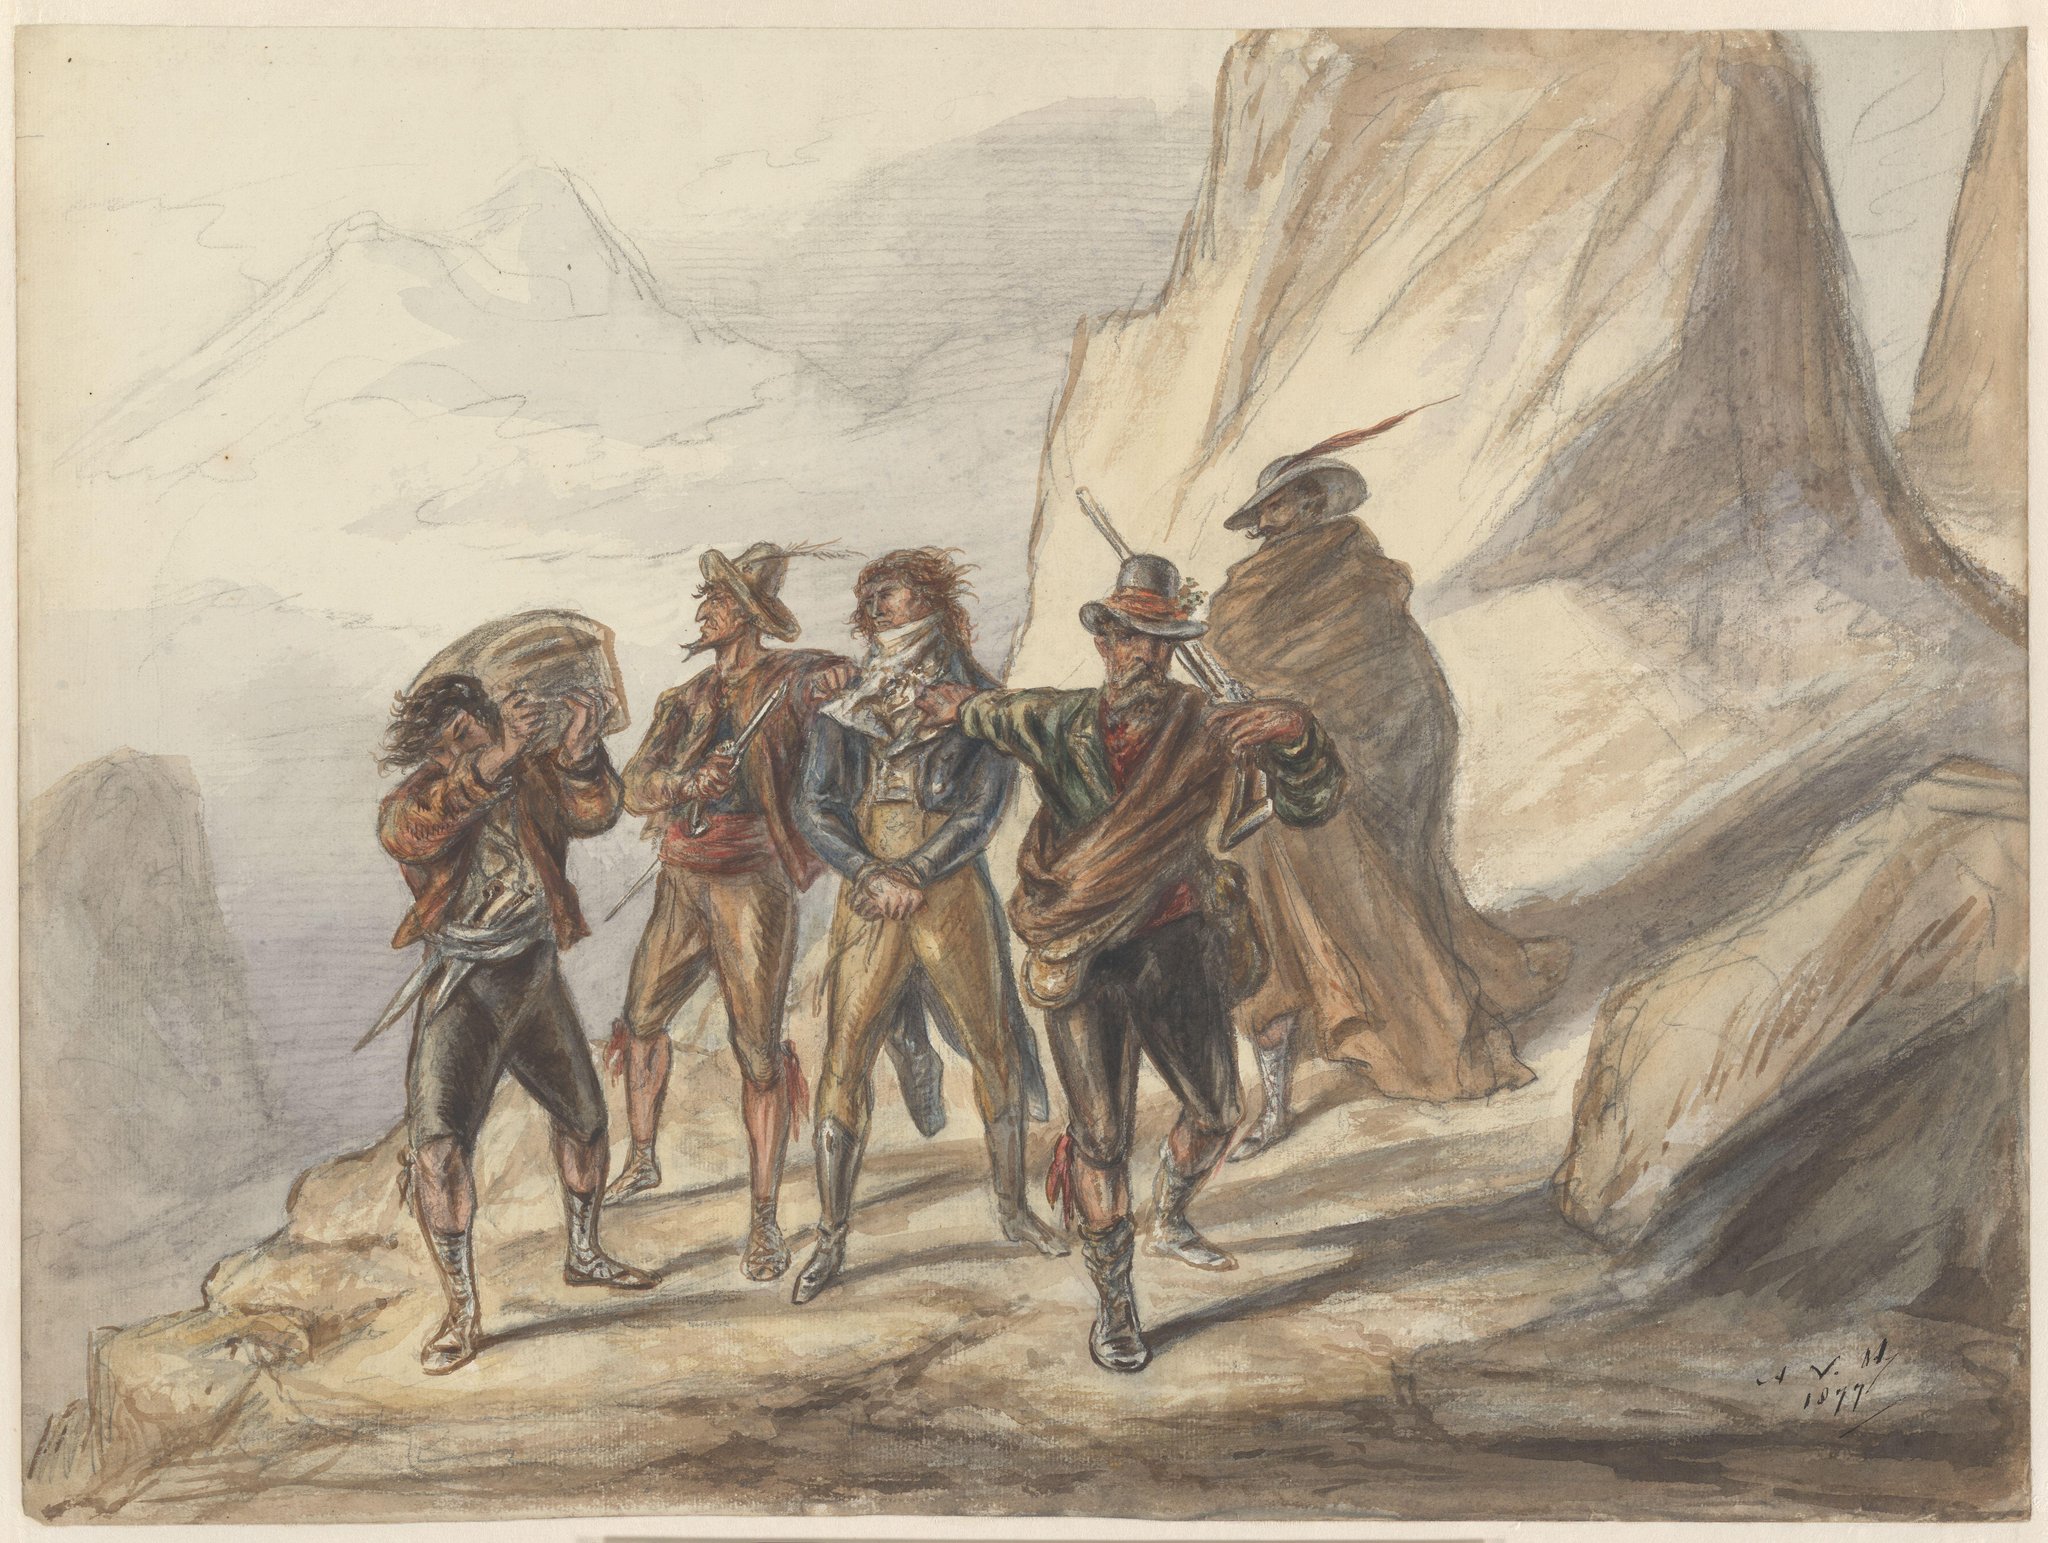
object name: drawing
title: Een overval in een berglandschap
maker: alexander ver huell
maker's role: draughtsman, print maker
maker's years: 1822-1897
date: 1877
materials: chalk, paper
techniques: brush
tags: robbery